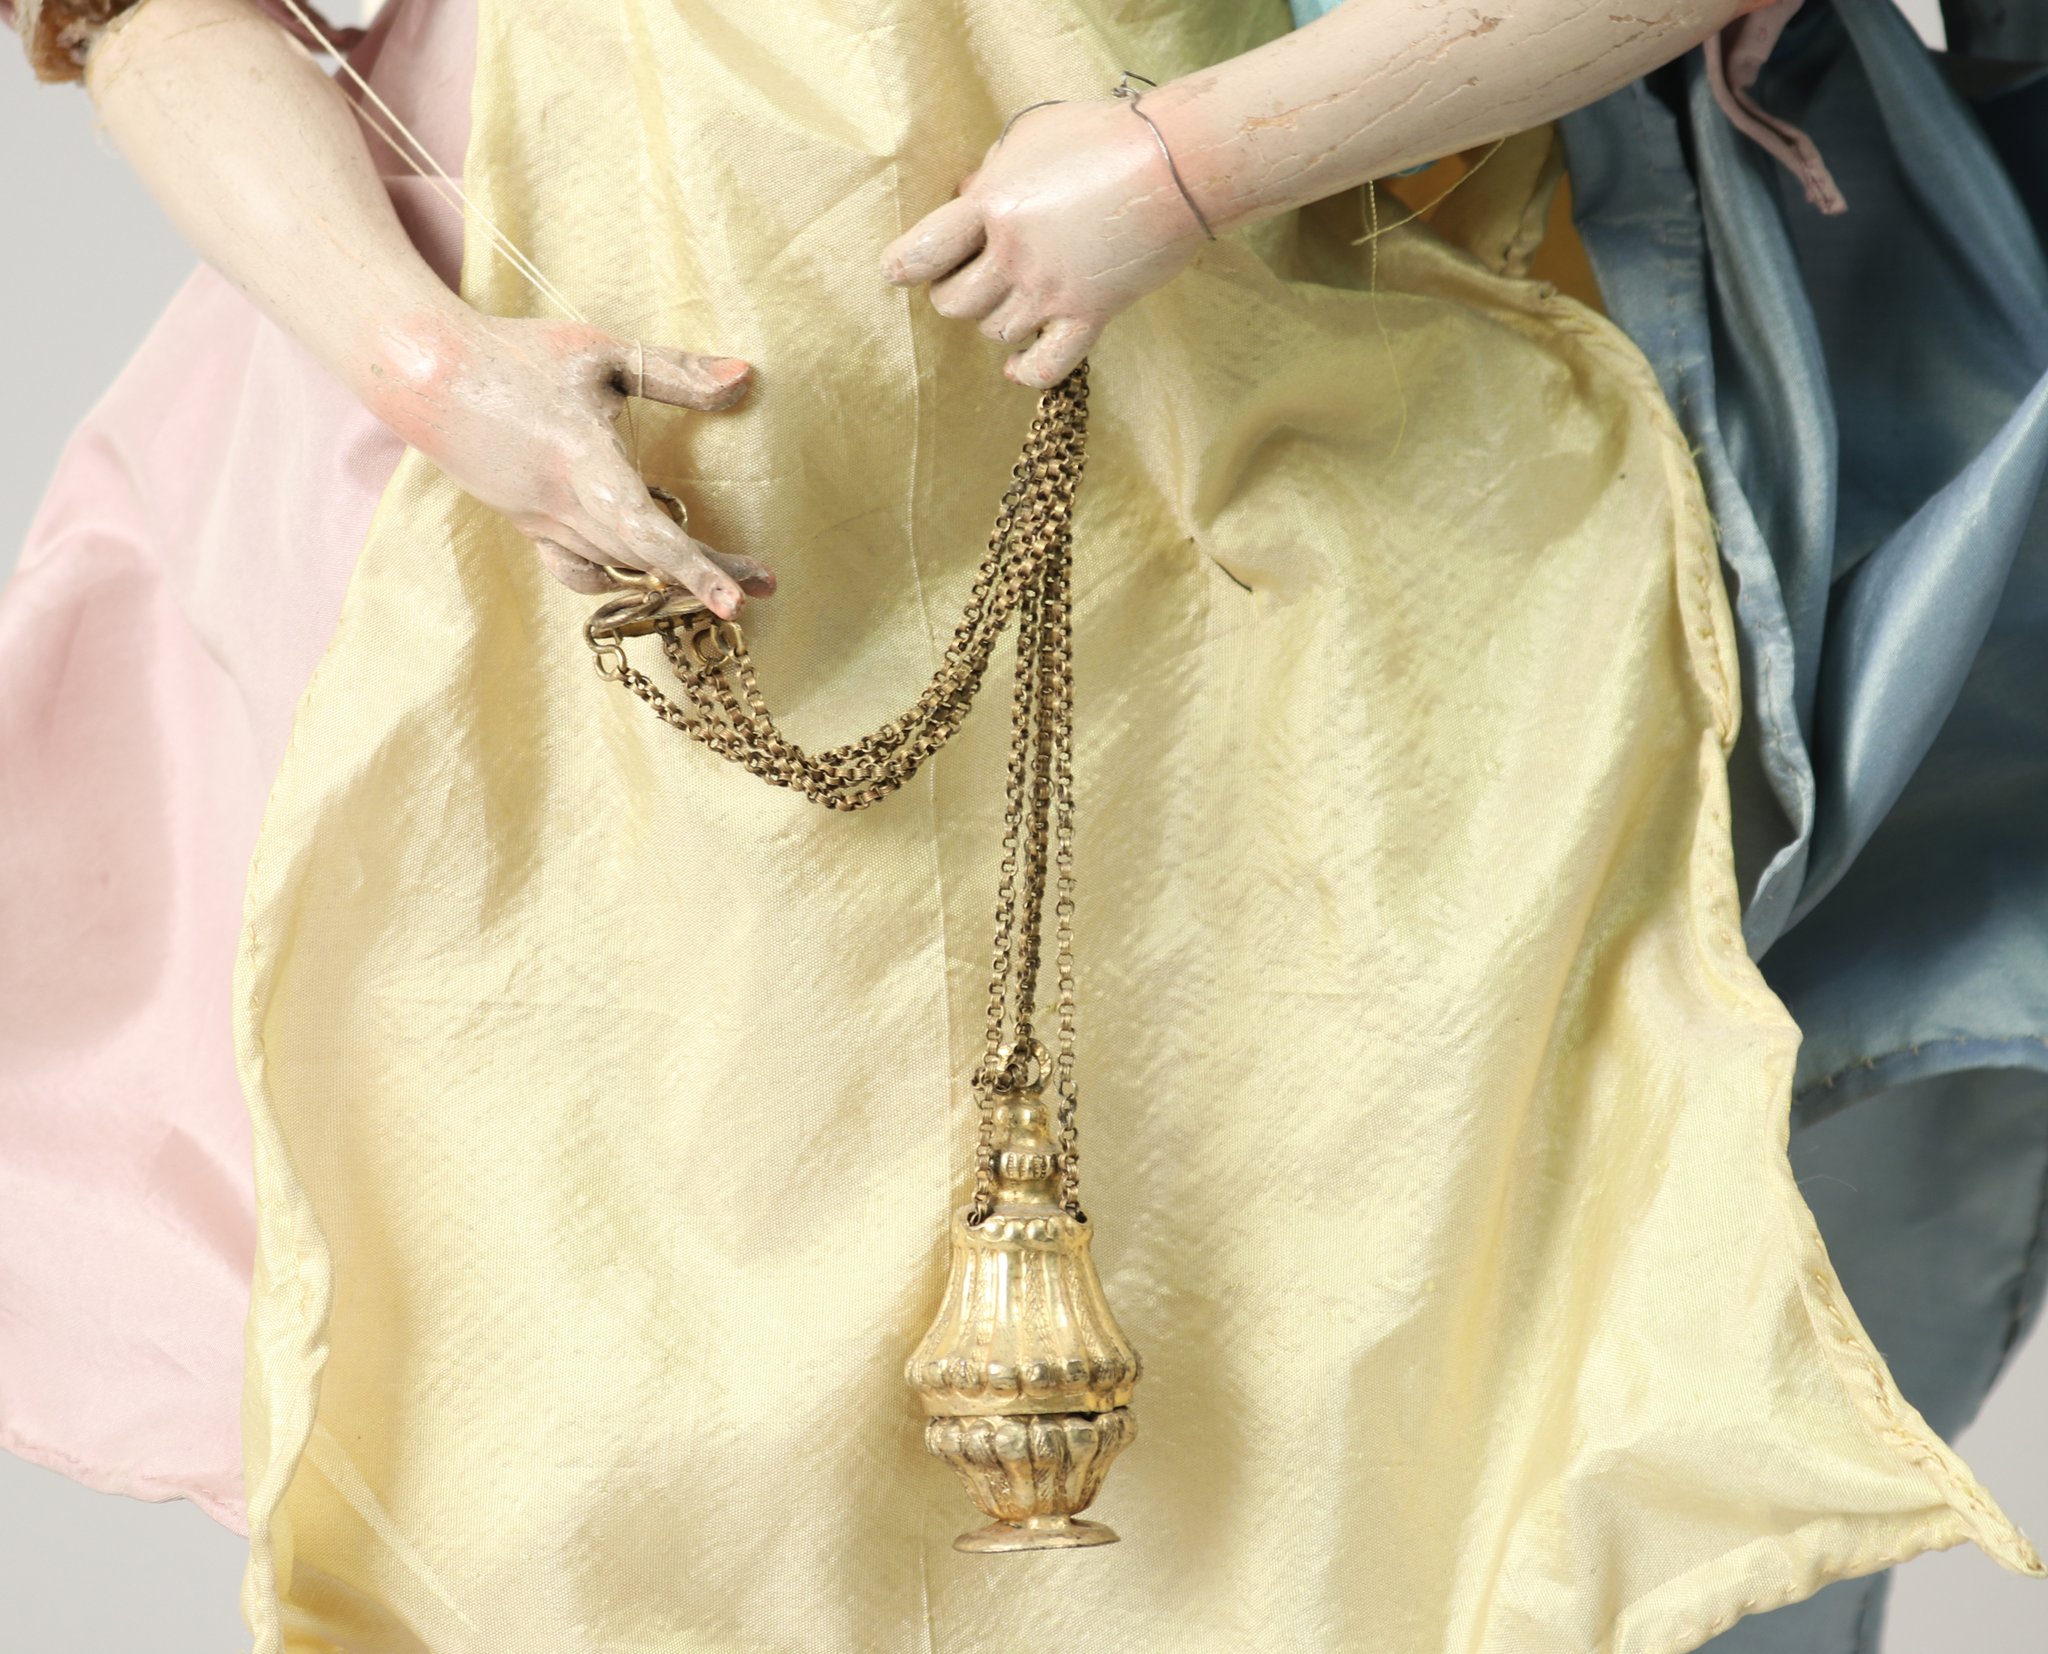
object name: crèche figure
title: Censer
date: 1751-1800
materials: silver gilt